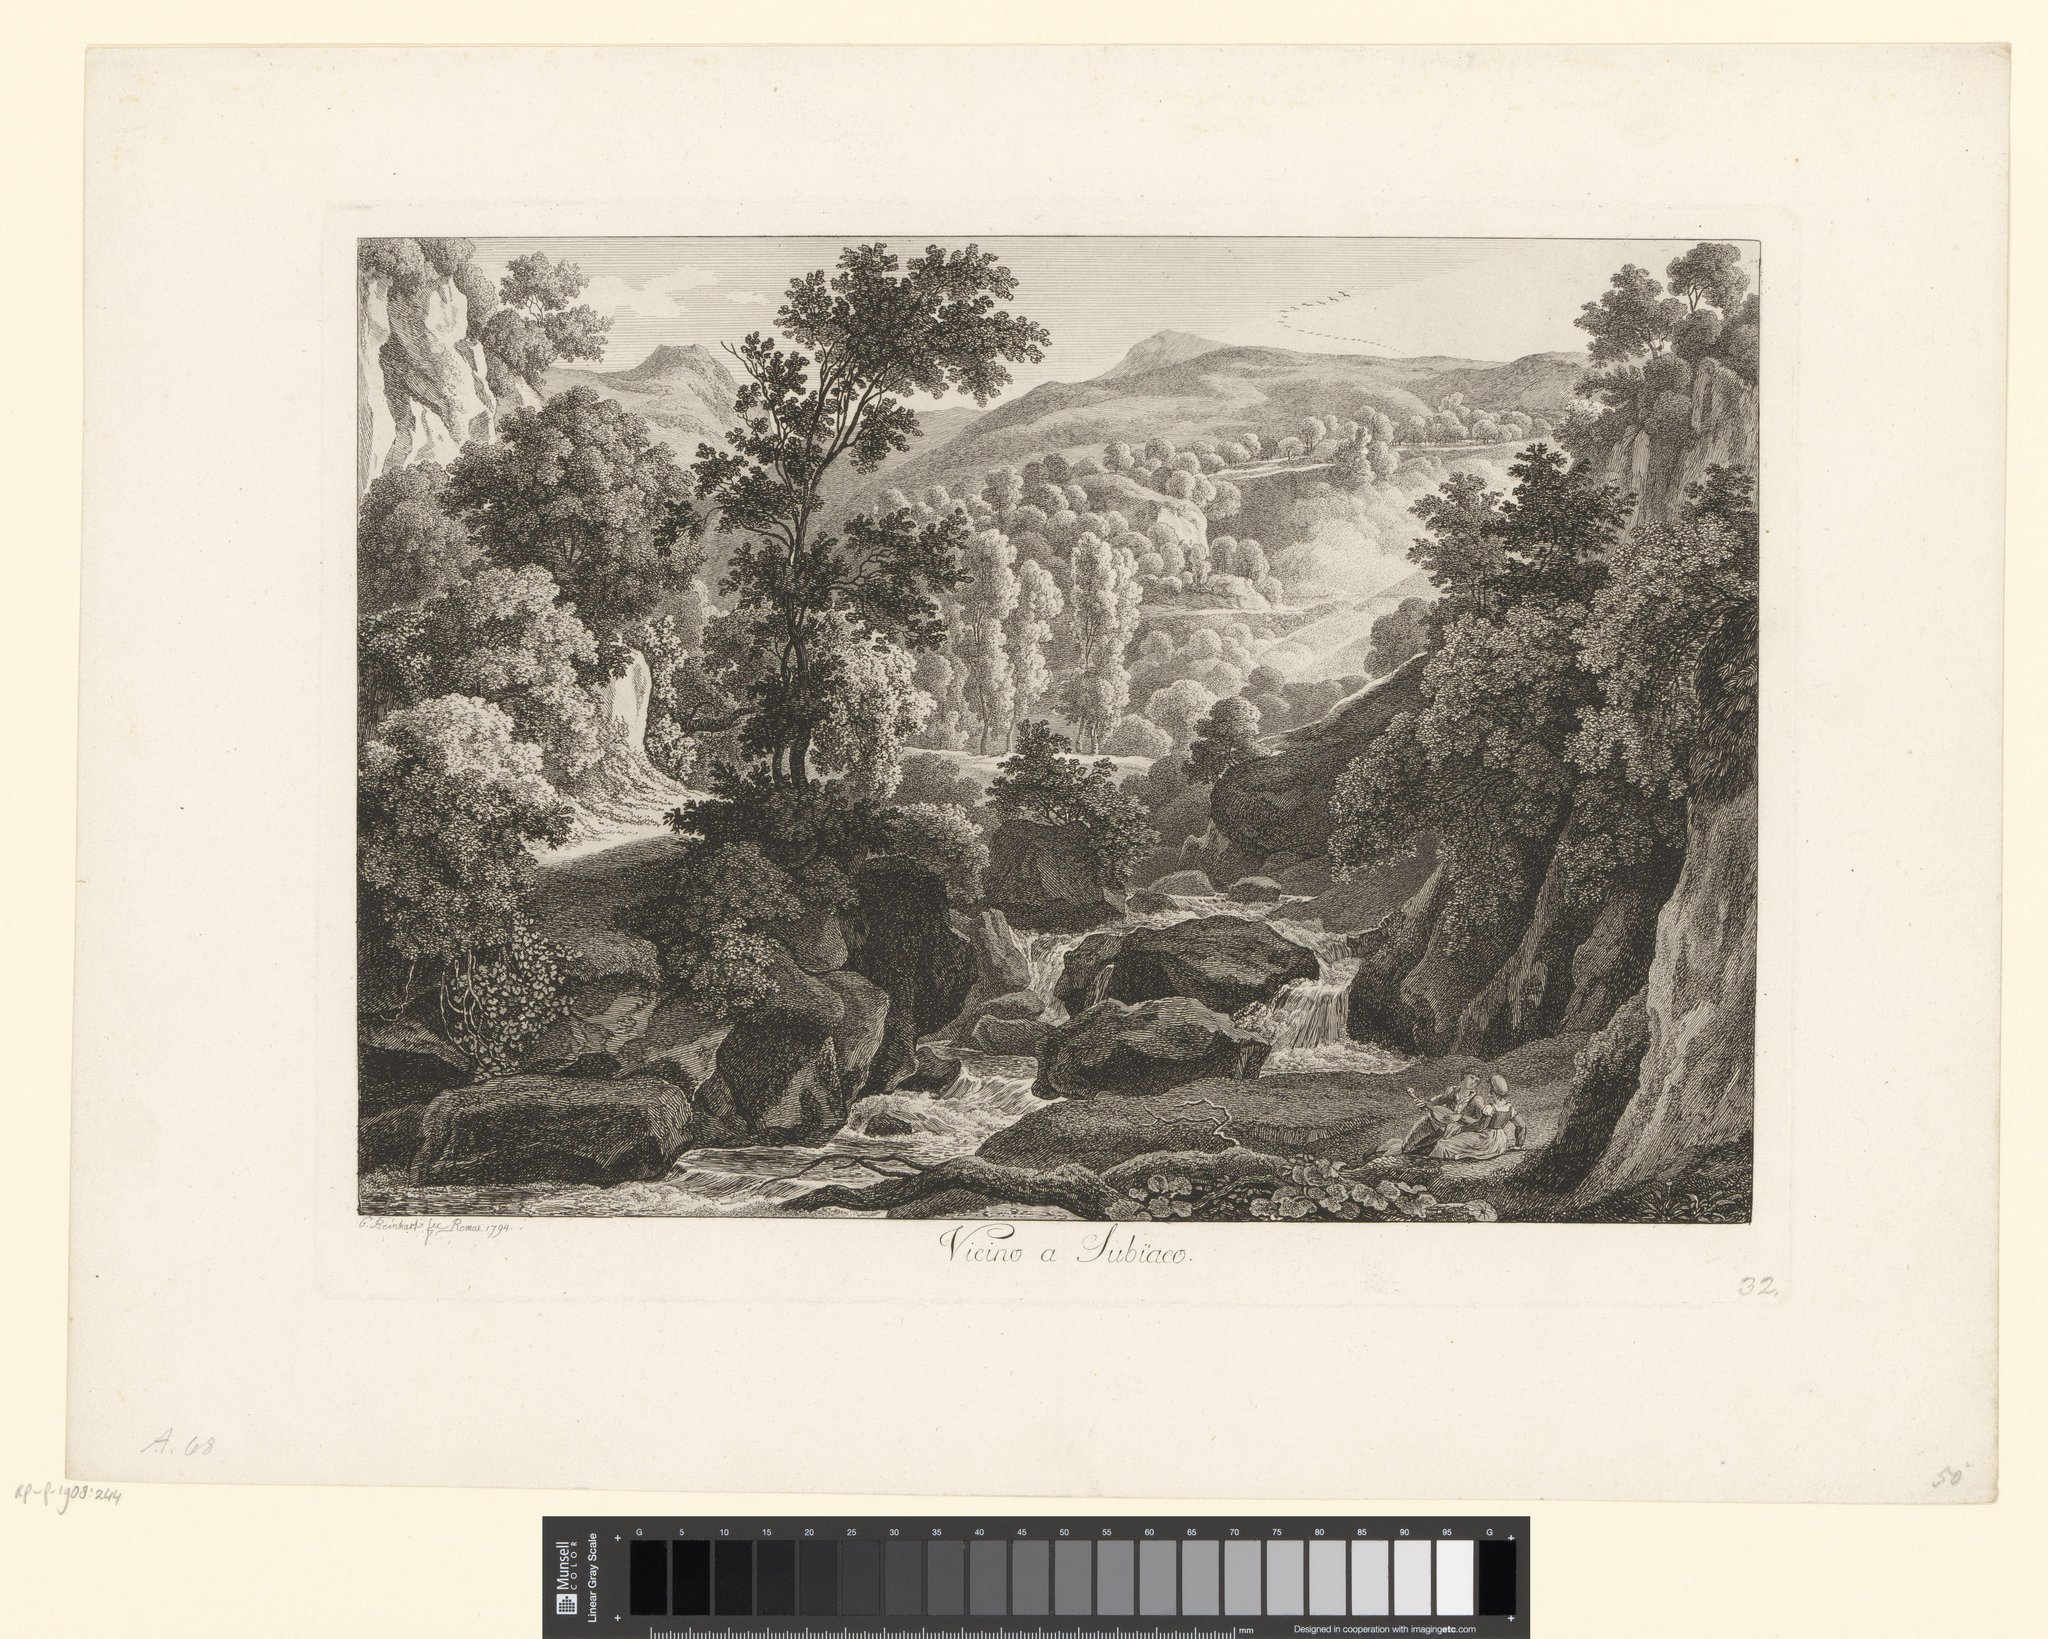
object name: print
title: Mahlerisch-radirte Prospecte von Italien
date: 1794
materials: paper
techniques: engraving, etching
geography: nuremberg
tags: landscapes, making music; musician with instrument - cc - out of doors, couple of lovers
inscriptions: collector's mark: Lugt 2228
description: Behorend tot een serie van 72 'Mahlerisch-radirte Prospecte von Italien', waarvoor de kunstenaar 24 prenten maakte. Albert Christoph Dies (1755-1822) en Jacob Wilhelm Mechau (1745-1808) maakten eveneens 24 platen, in opdracht van Jean Fréderic Frauenholz. Vanaf 1792 verschenen telkens drie sets van twee prenten per kunstenaar. In 1798 werd de laatste set uitgegeven, waarna complete sets gebonden werden uitgegeven tot in 1875 (Nuerenberg: J.L. Lotzbeck). Zie: Schmid, F.C., A.C. Dies, J.W. Mechau und J.C. Reinhart 'Mahlerische radirte Prospecte von Italien' (...). Berlijn: s.n., 1991.